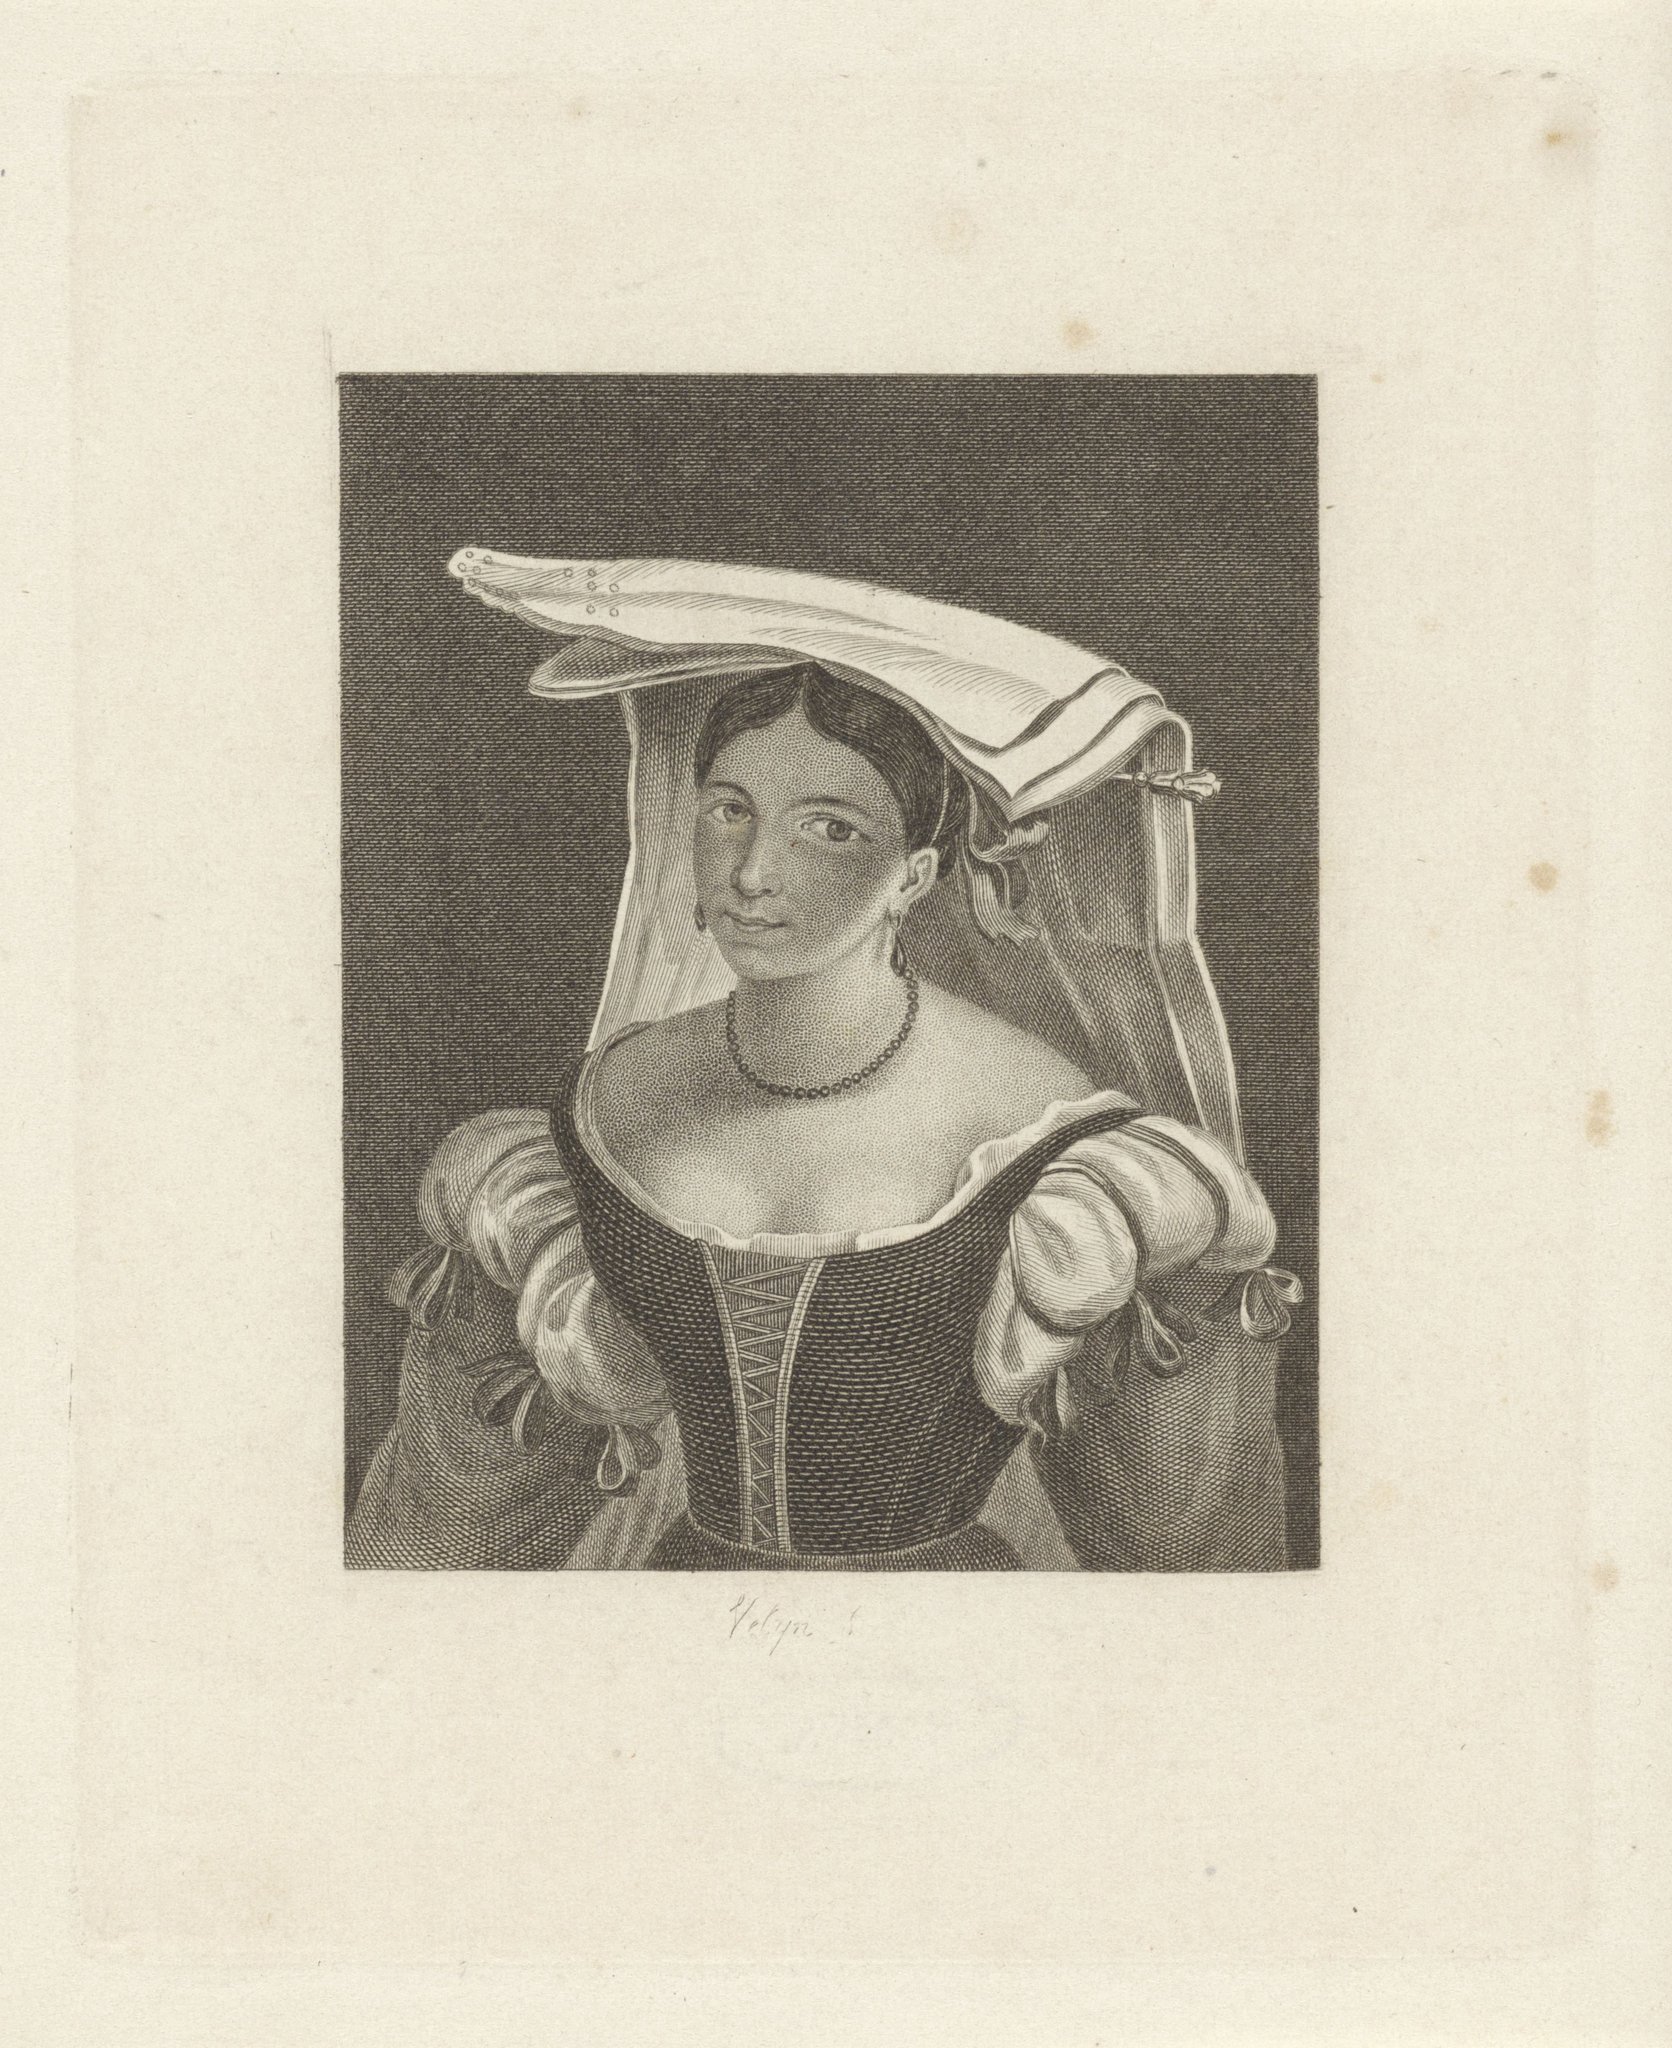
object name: print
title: Vrouw in klederdracht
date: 1797-1836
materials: paper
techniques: engraving, etching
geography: netherlands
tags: adolescent, young woman, maiden, head-gear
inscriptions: collector's mark: Lugt 2228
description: Een jonge vrouw in landelijke klederdracht.